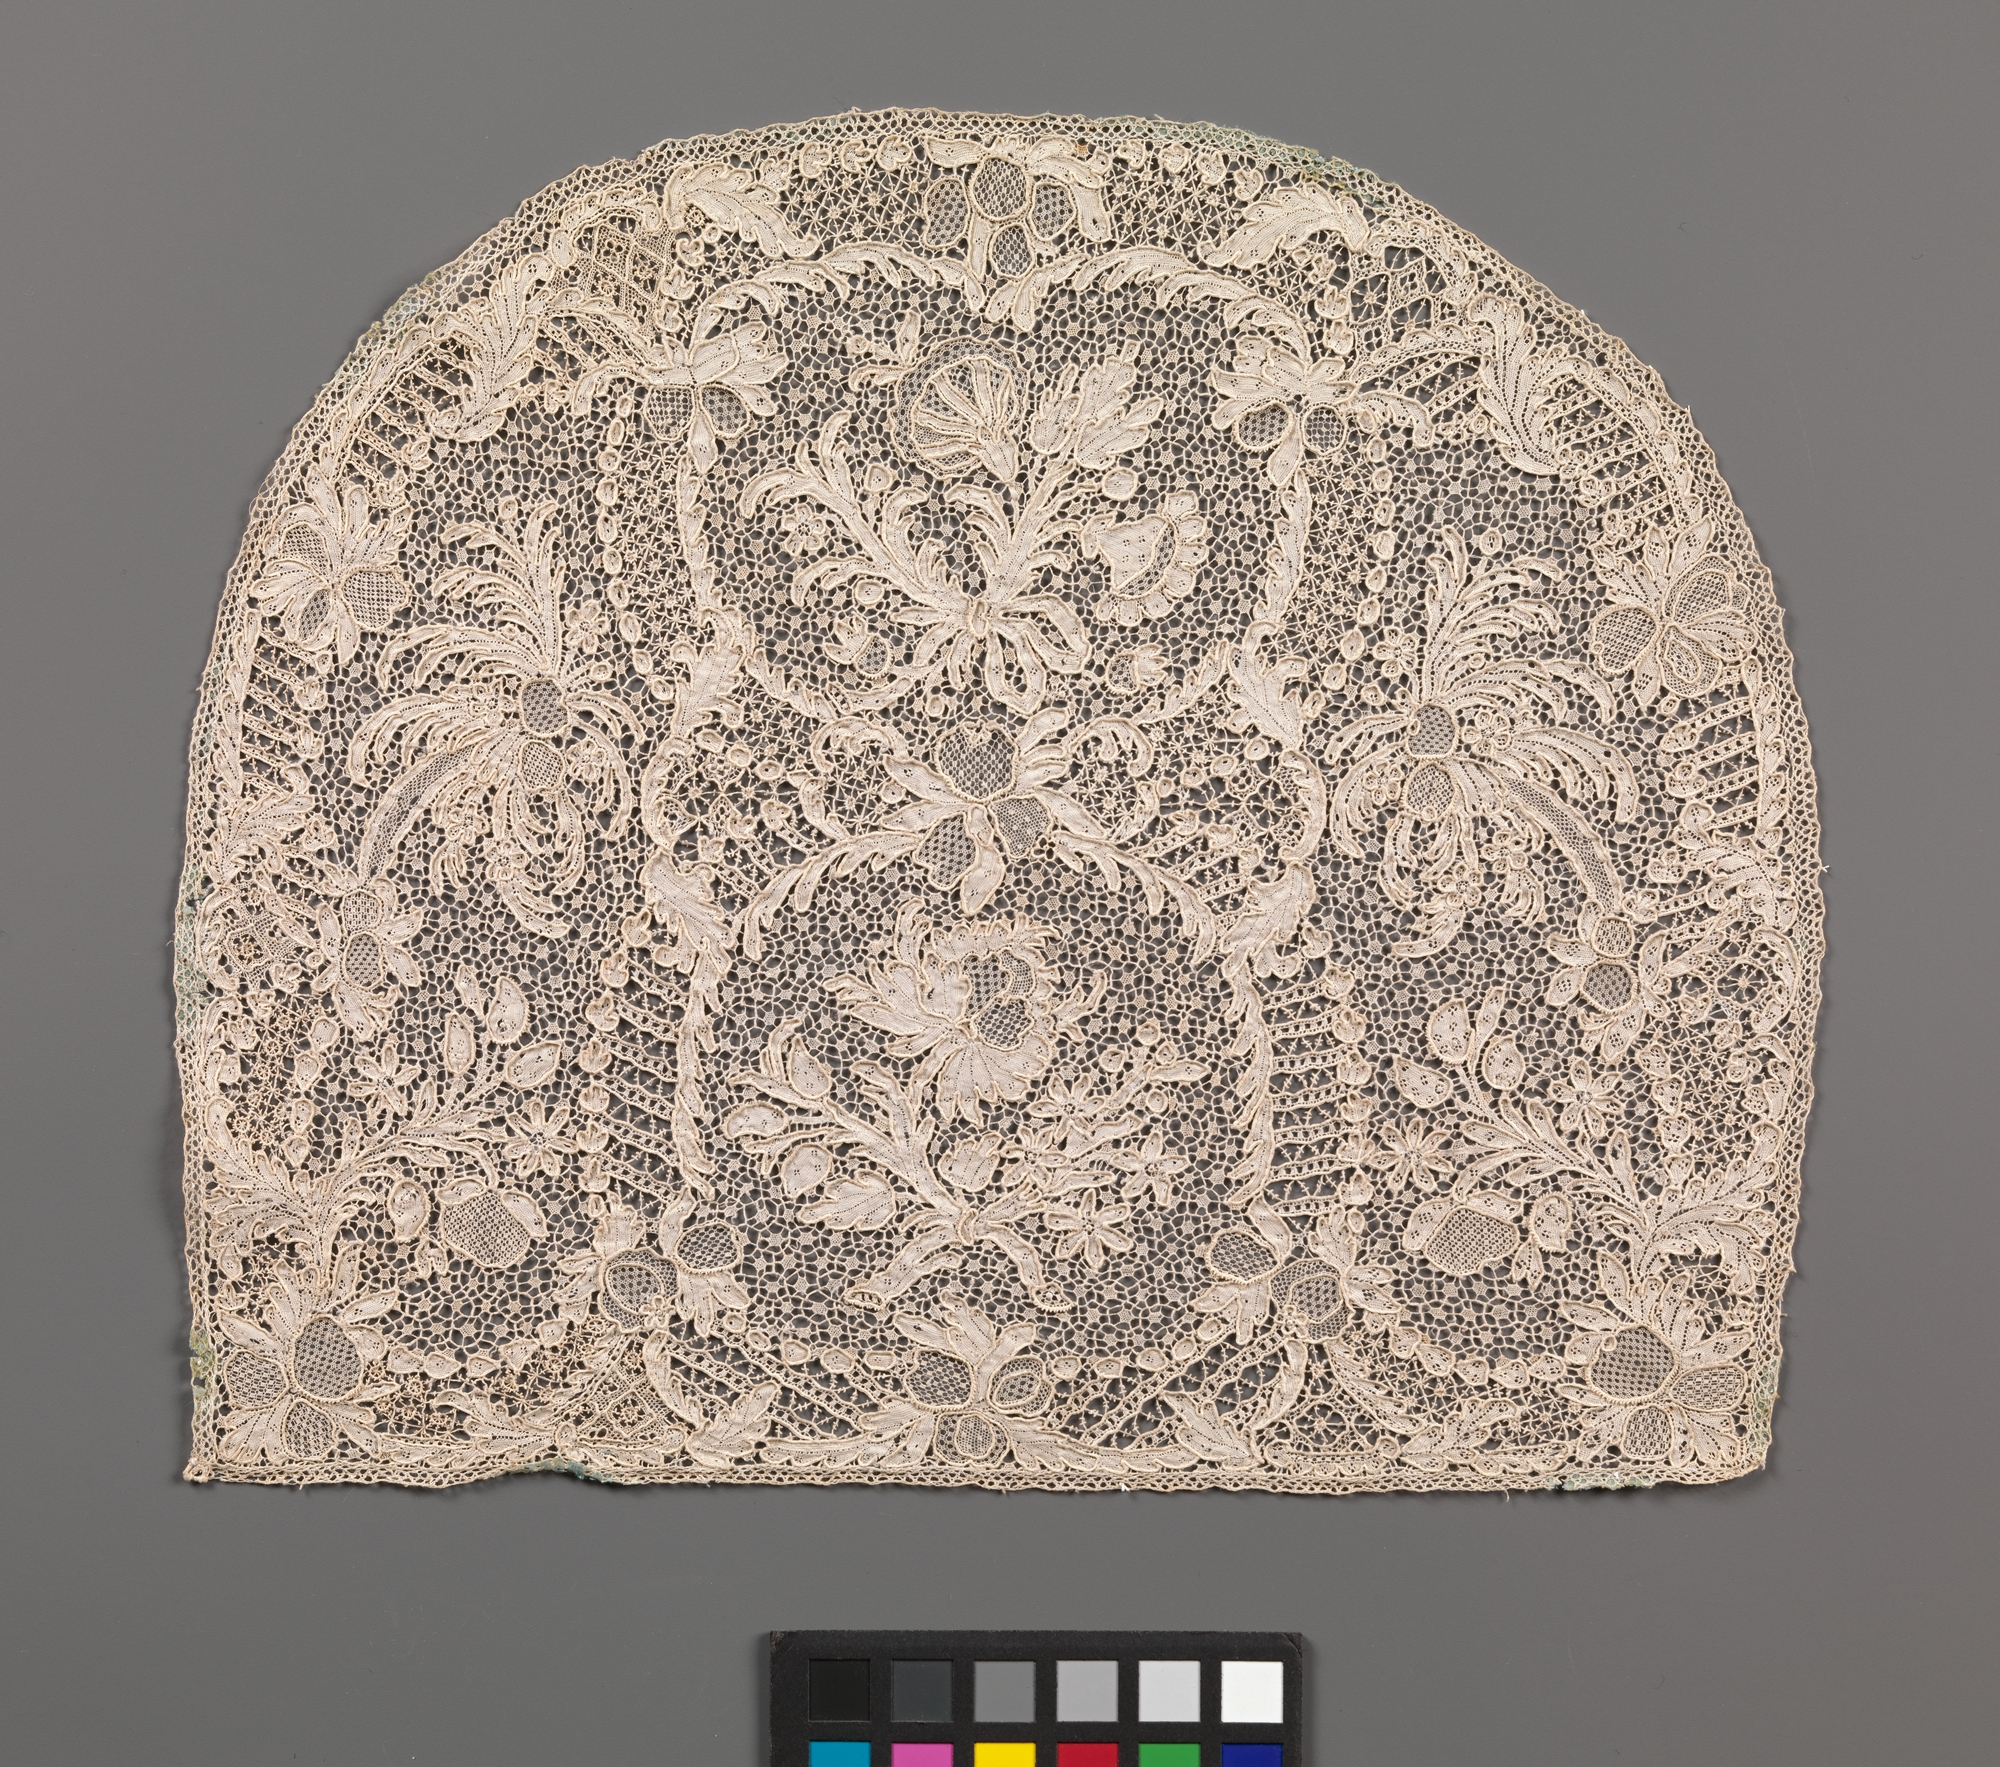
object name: cap crown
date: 1720-1740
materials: linen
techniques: lace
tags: flowers